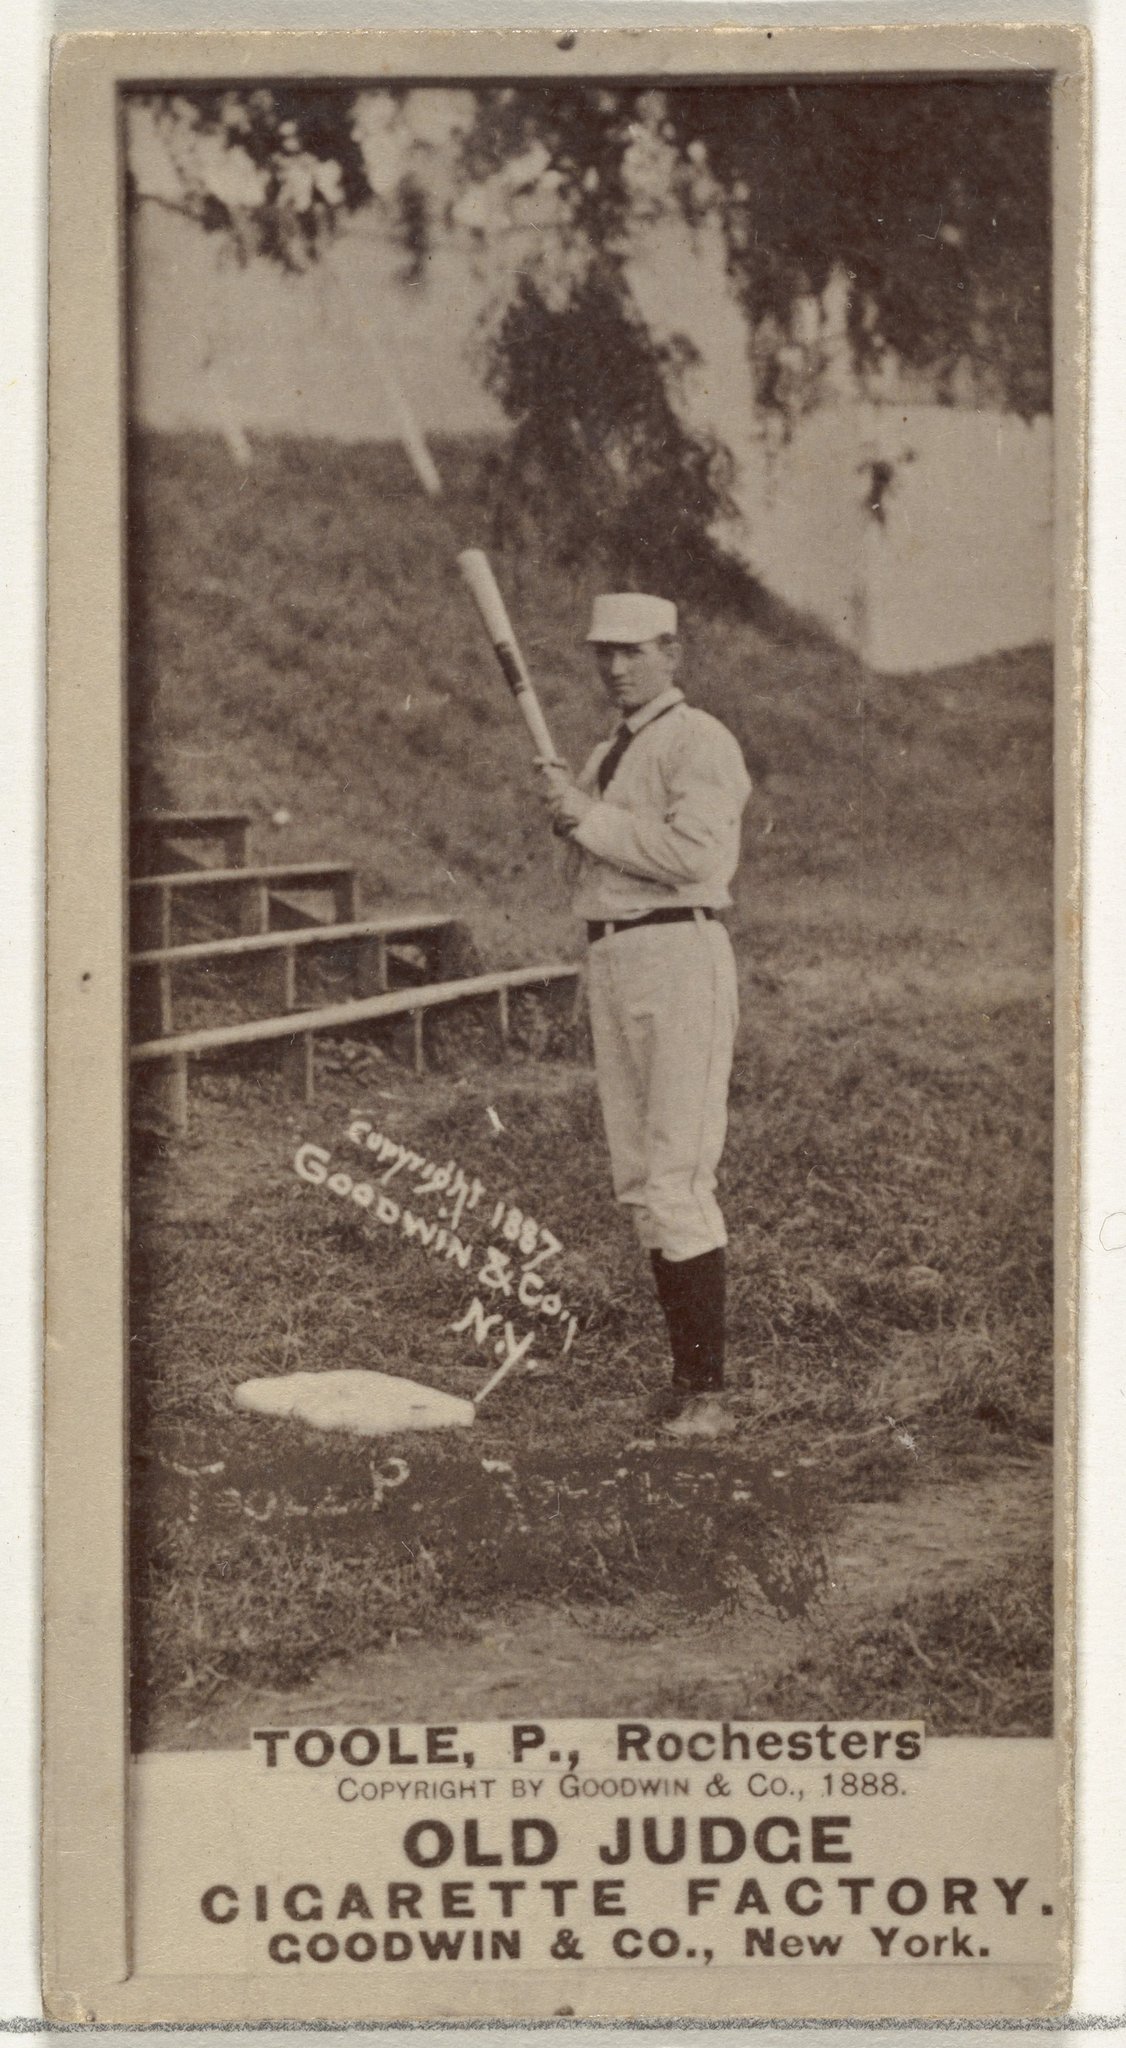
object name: baseball card, photograph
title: Stephen John "Steve" Toole, Pitcher, Rochester, from the Old Judge series (N172) for Old Judge Cigarettes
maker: goodwin & company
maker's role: publisher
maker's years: 1850-1950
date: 1887-1888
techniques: albumen silver print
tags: men,portraits,baseball,athletes